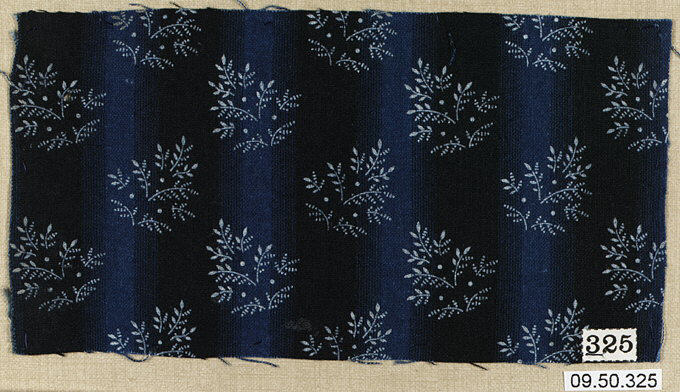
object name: piece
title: Piece (one of 116)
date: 1801-1900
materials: cotton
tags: leaves